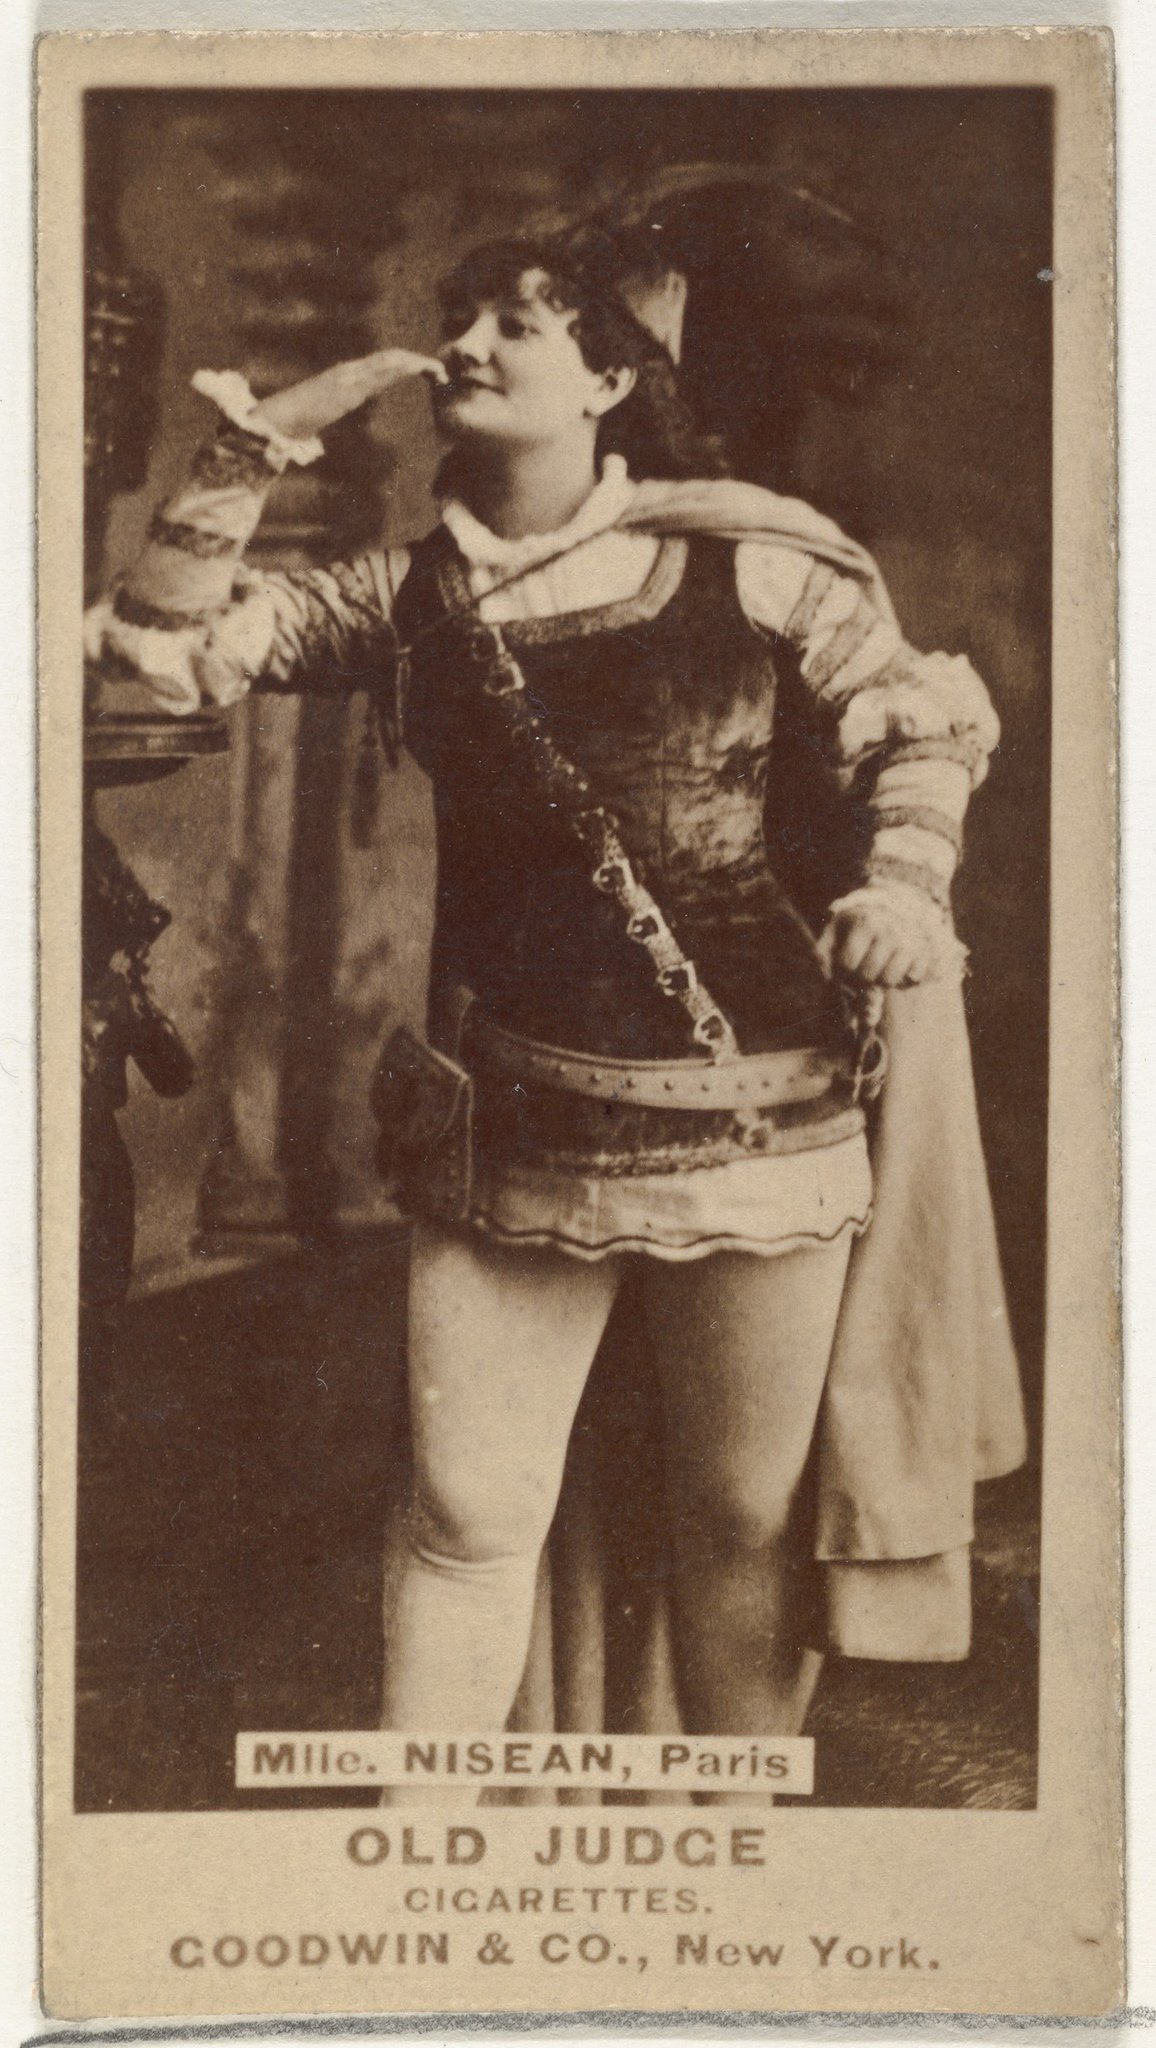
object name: photograph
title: Mlle. Nisean, Paris, from the Actors and Actresses series (N171) for Old Judge Cigarettes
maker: goodwin & company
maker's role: publisher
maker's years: 1850-1950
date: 1886-1890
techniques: albumen silver print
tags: portraits,women,actresses